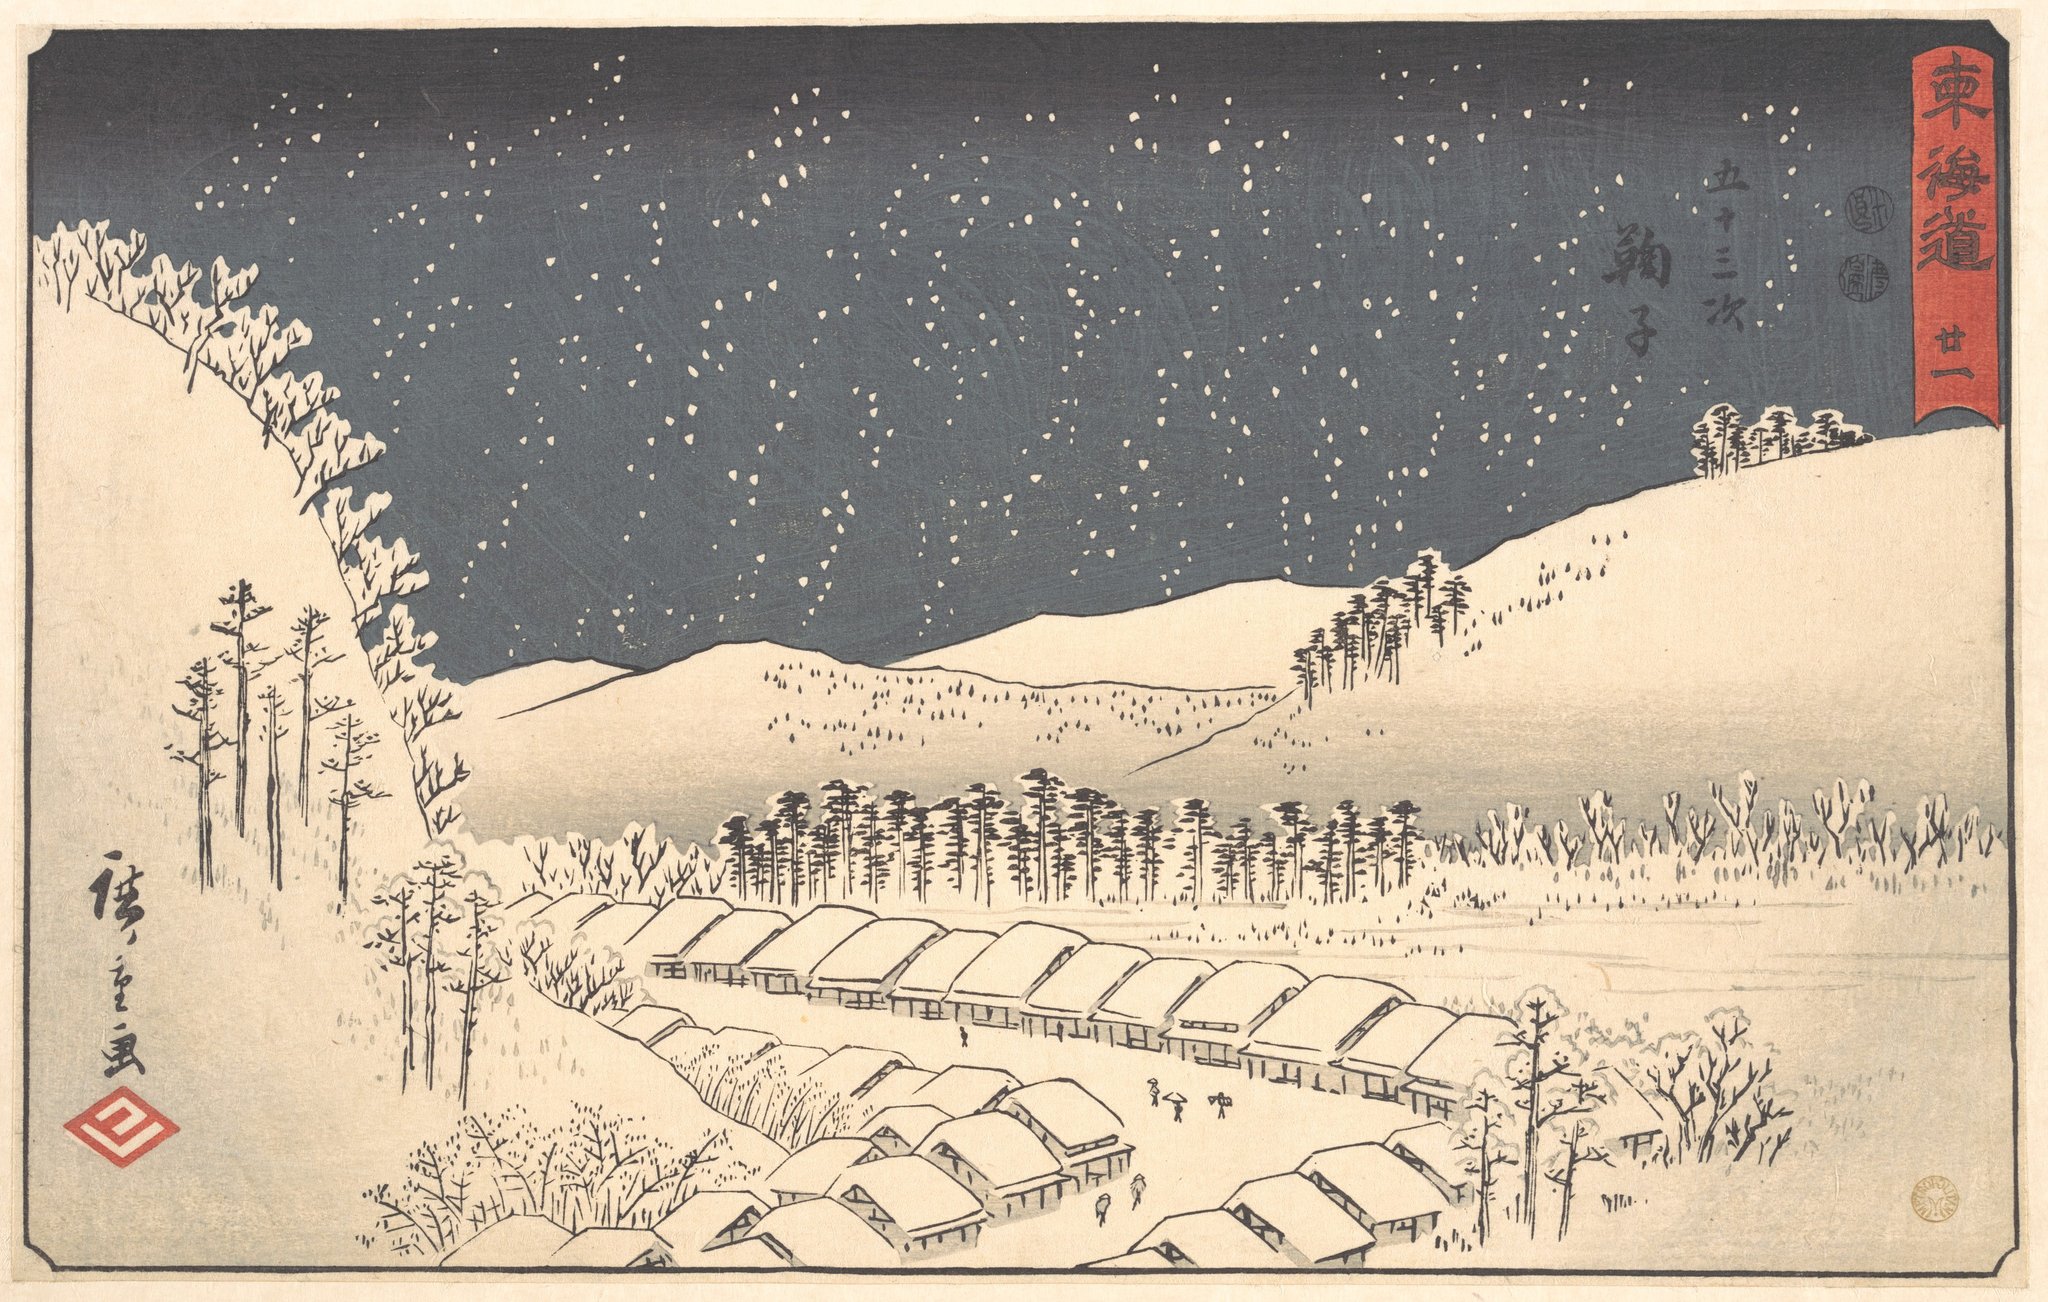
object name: print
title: Mariko, from the series Tokaidō (popularly known as the Reisho Tokaidō)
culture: japanese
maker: utagawa hiroshige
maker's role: artist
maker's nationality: japanese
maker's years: 1797-1858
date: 1840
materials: ink, paper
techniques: woodblock print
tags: houses,trees,snow